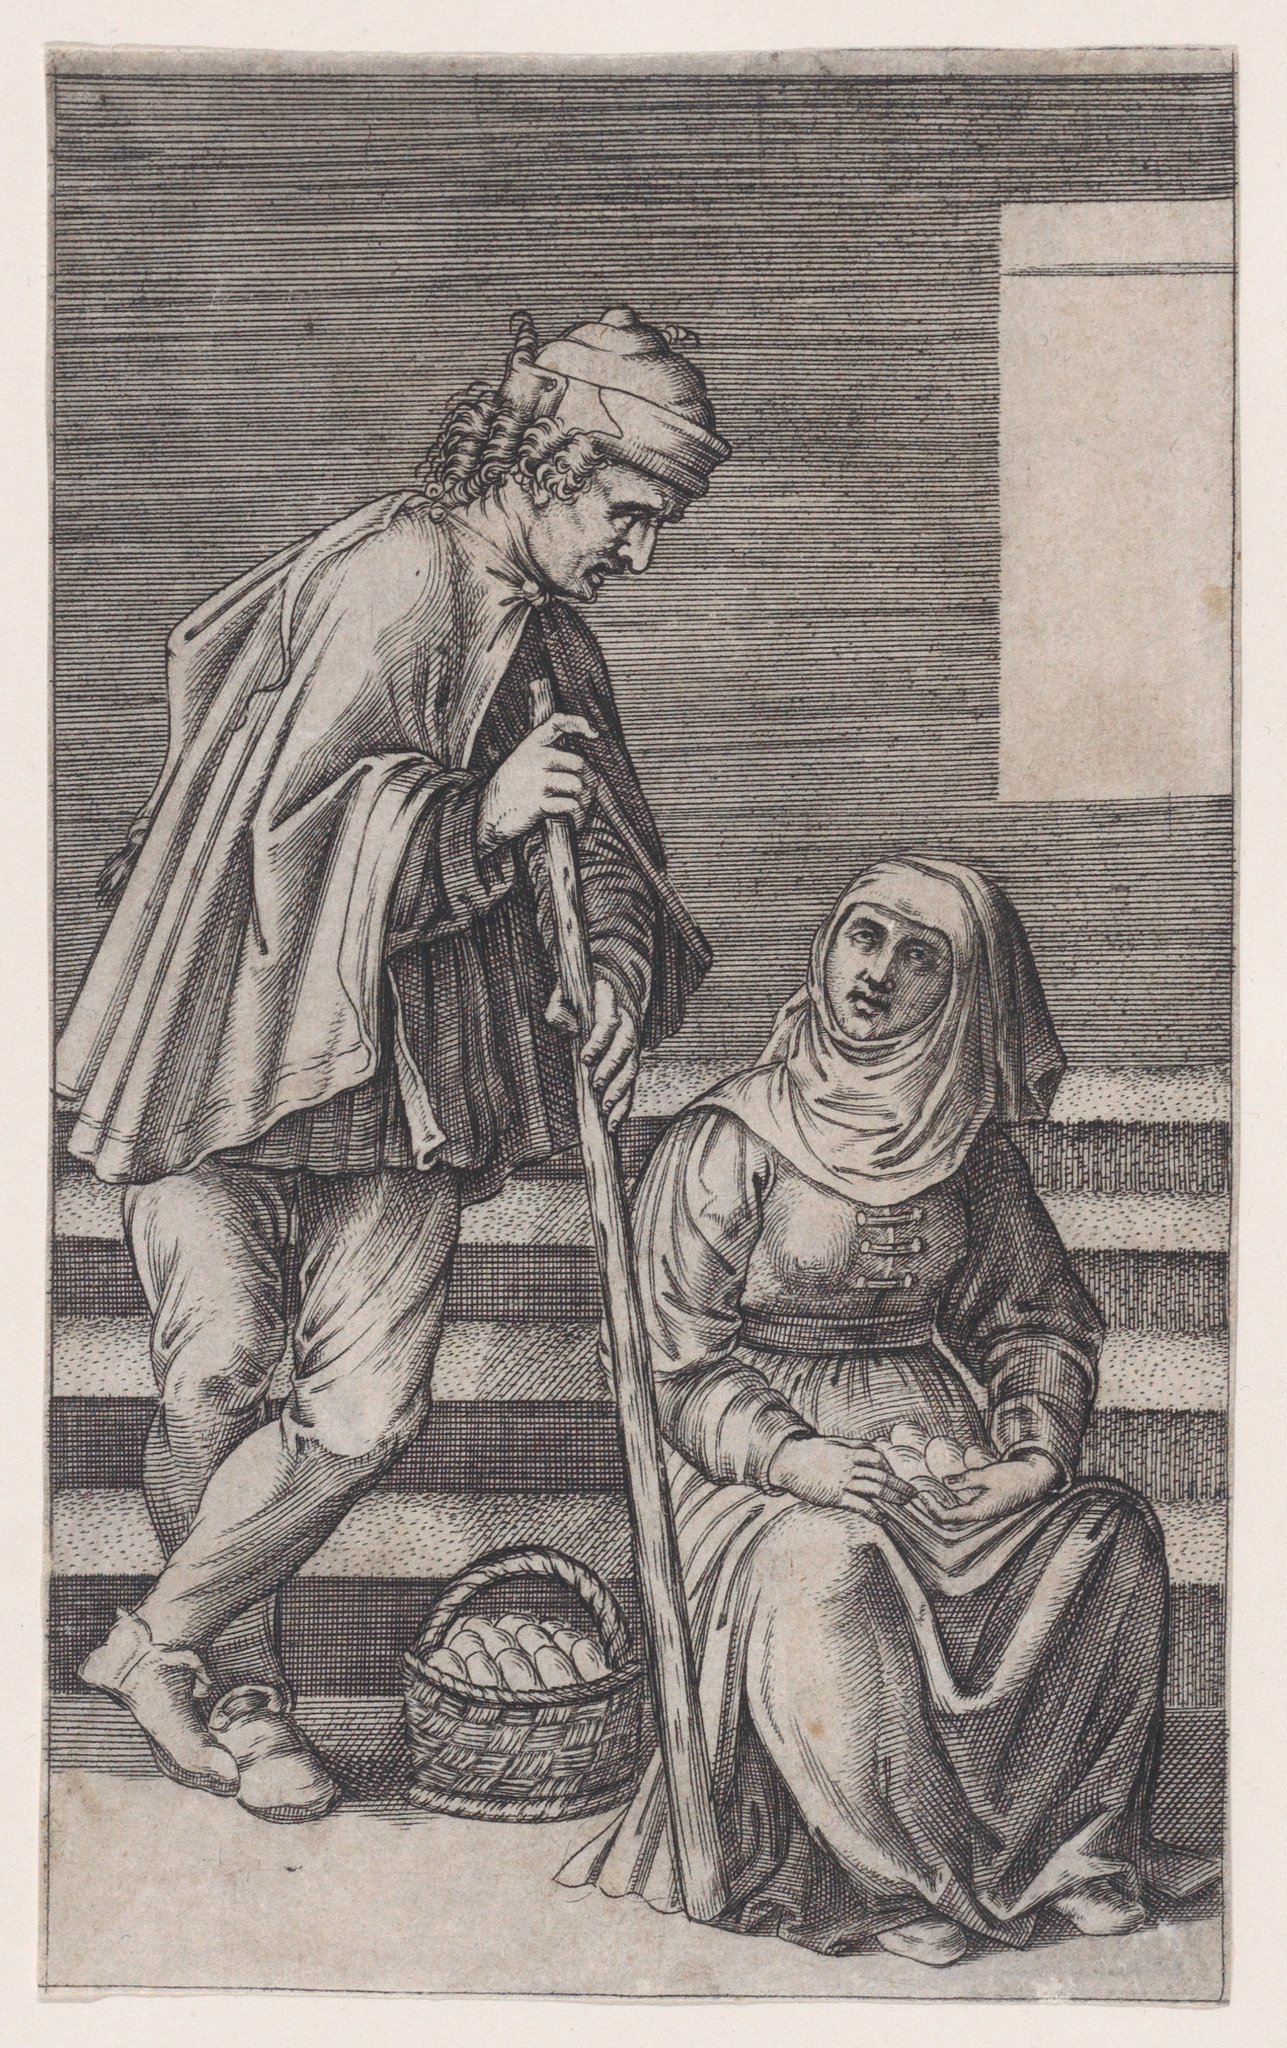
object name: print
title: Peasant and a Woman with Eggs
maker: agostino veneziano (agostino dei musi)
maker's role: artist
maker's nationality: italian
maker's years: 1490-1536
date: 1514-1536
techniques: engraving